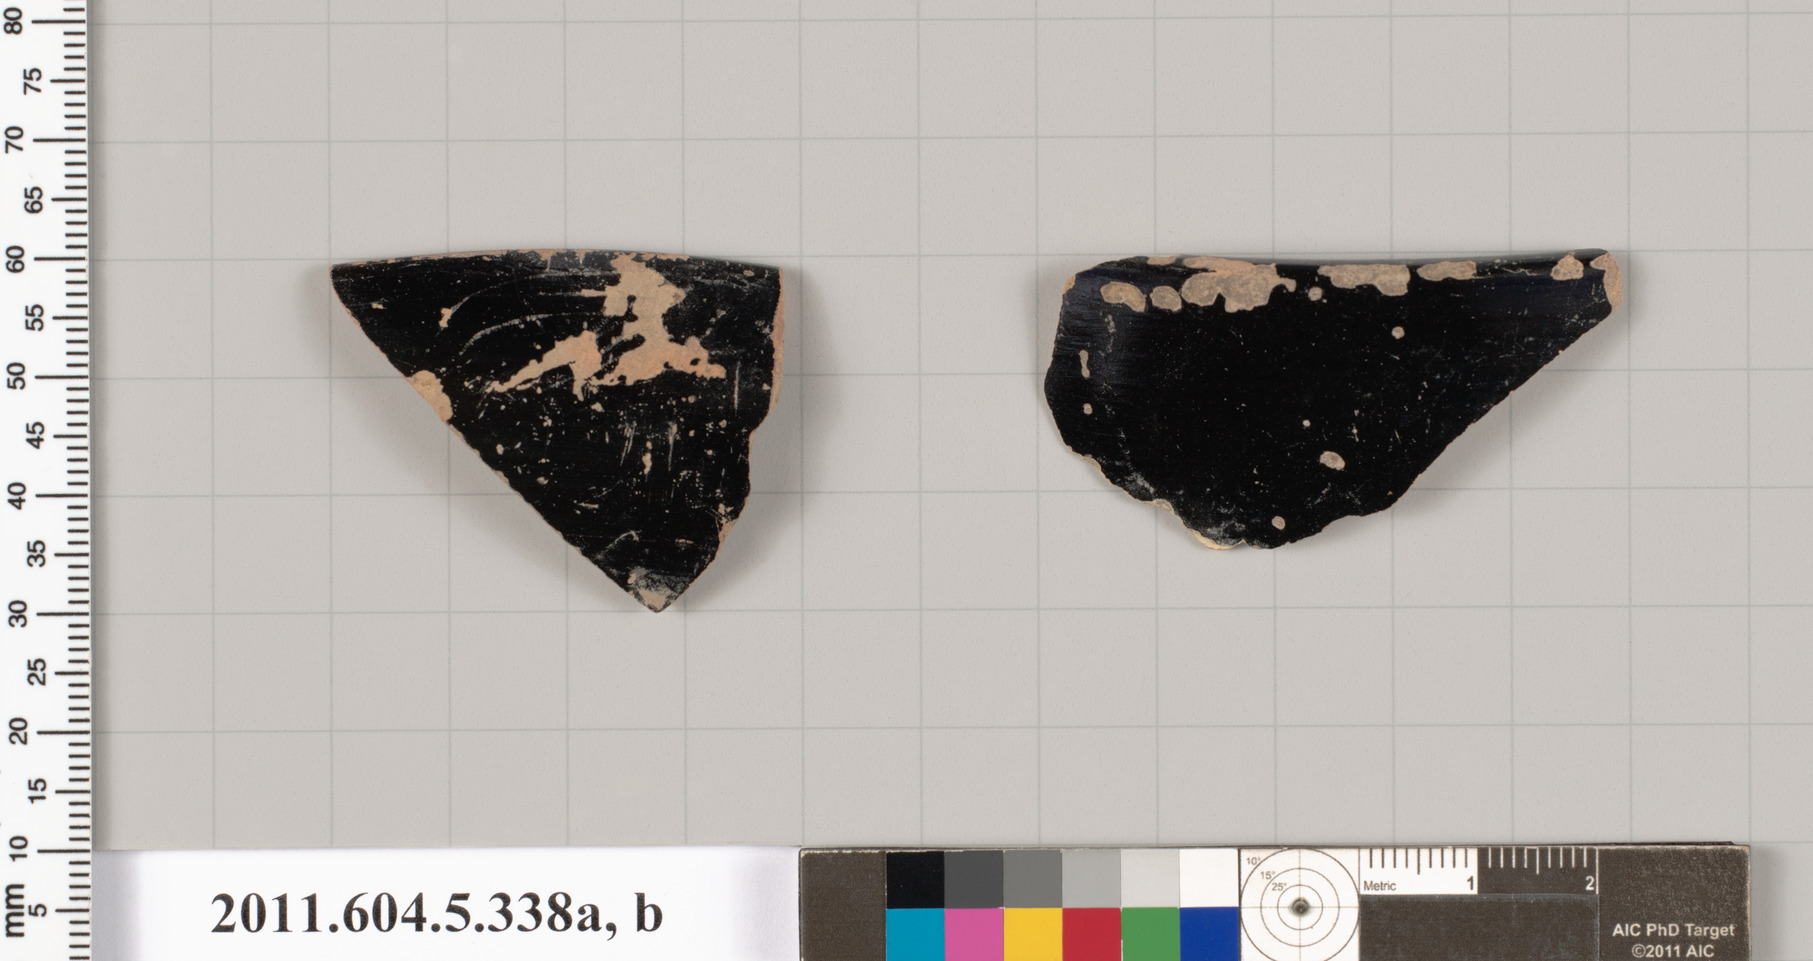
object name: kylix fragment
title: Terracotta rim fragments of kylikes (drinking cups)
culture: greek, attic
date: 600-401 BCE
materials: terracotta